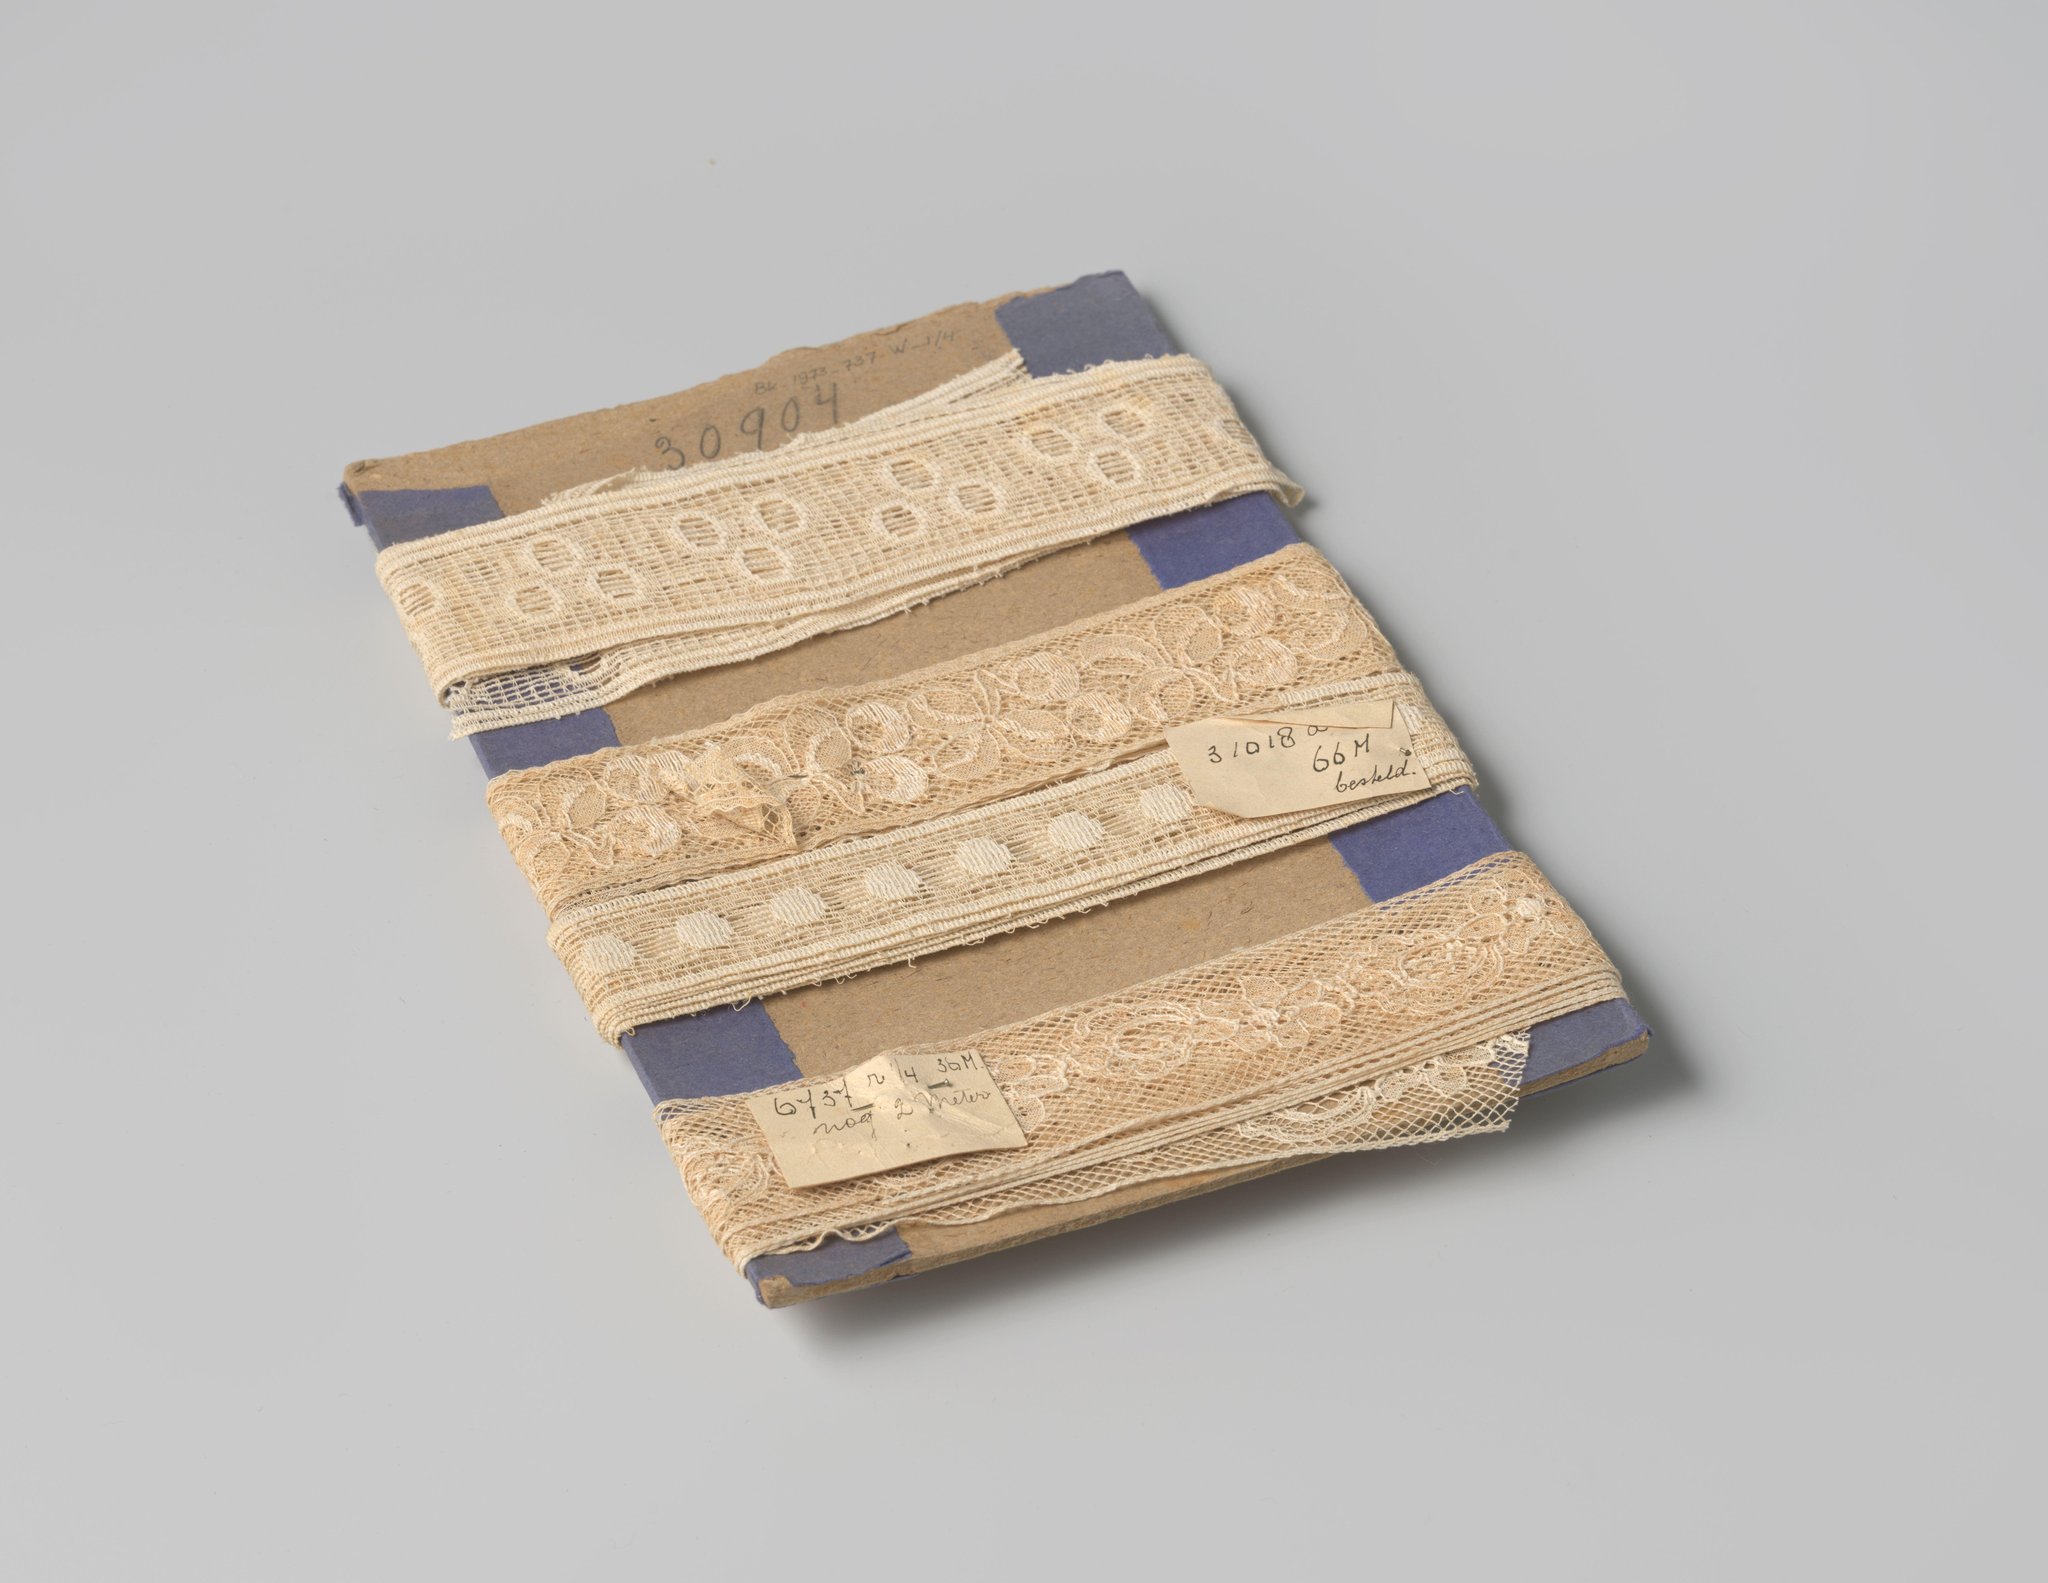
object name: entre deux, tussenzetsel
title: Tussenzetsel van roomwitte machinale kant met patroon van cirkels, op karton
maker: gustav schnitzler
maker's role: paraplufabrikant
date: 1925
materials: cardboard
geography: nijmegen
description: Tussenzetsel van roomwitte machinale kant met patroon van cirkels, op karton.